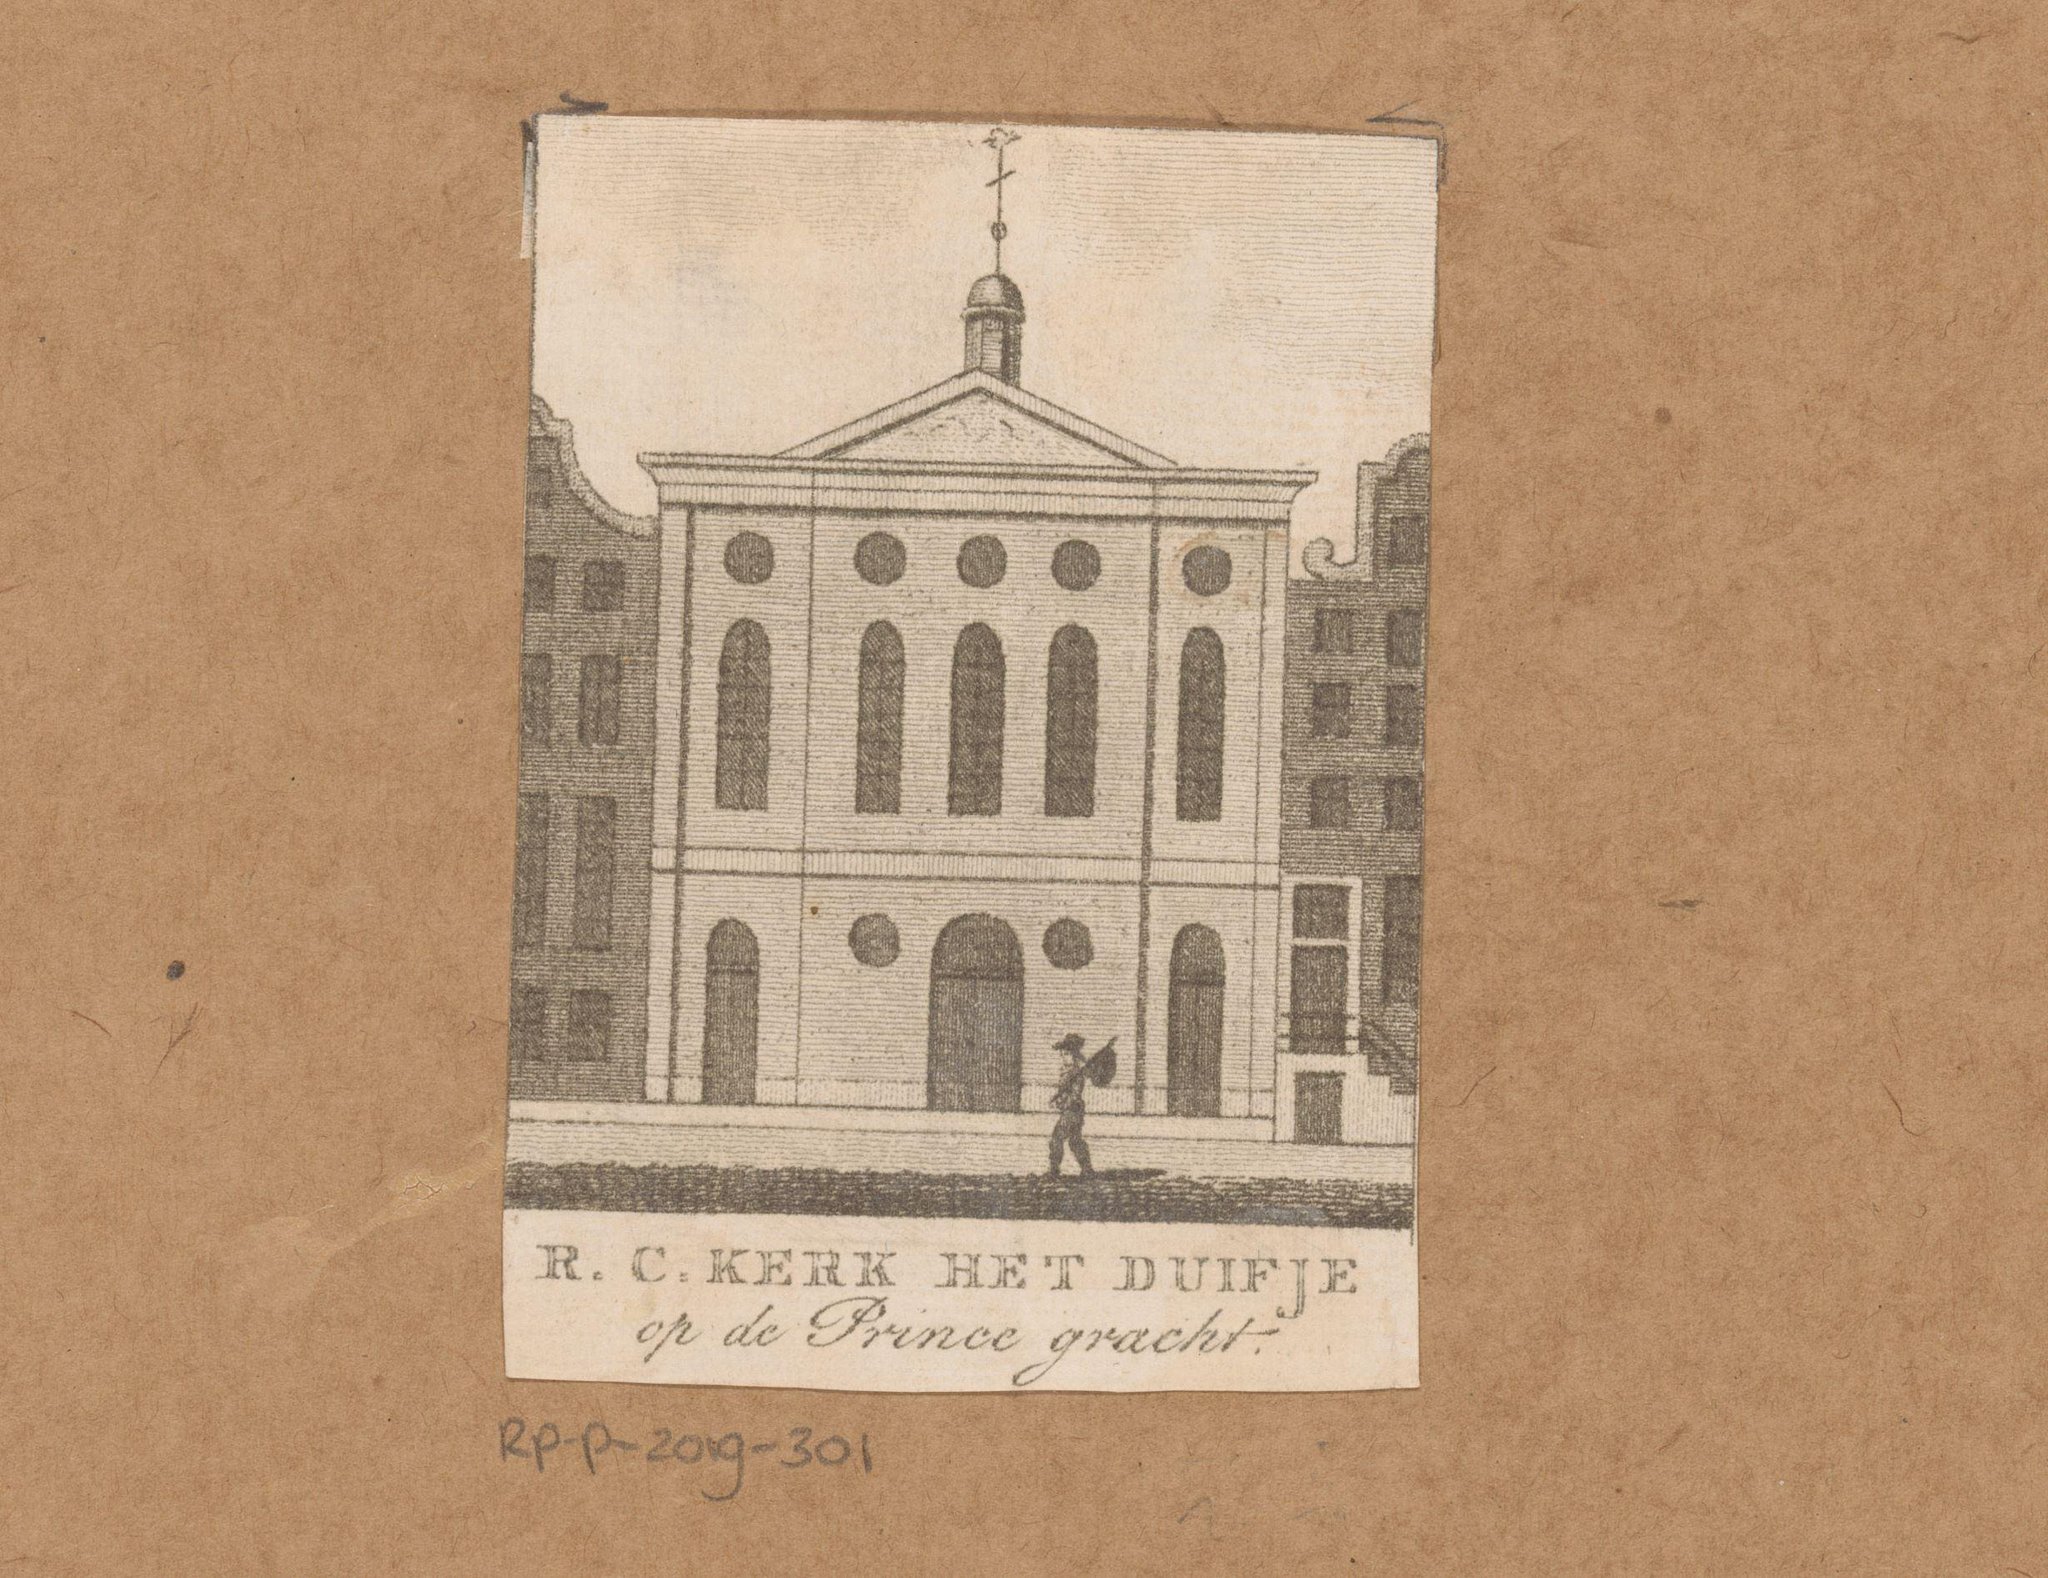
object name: print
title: R.C. Kerk Het Duifje op de Prince gracht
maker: Anonymous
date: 1800-1840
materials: paper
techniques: etching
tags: roman catholic church, amsterdam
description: De Rooms Katholieke schuilkerk Het Vrede-Duifje is in 1796 vervangen door De Duif (Heilige Willibrordus binnen de Veste) aan de Prinsengracht.